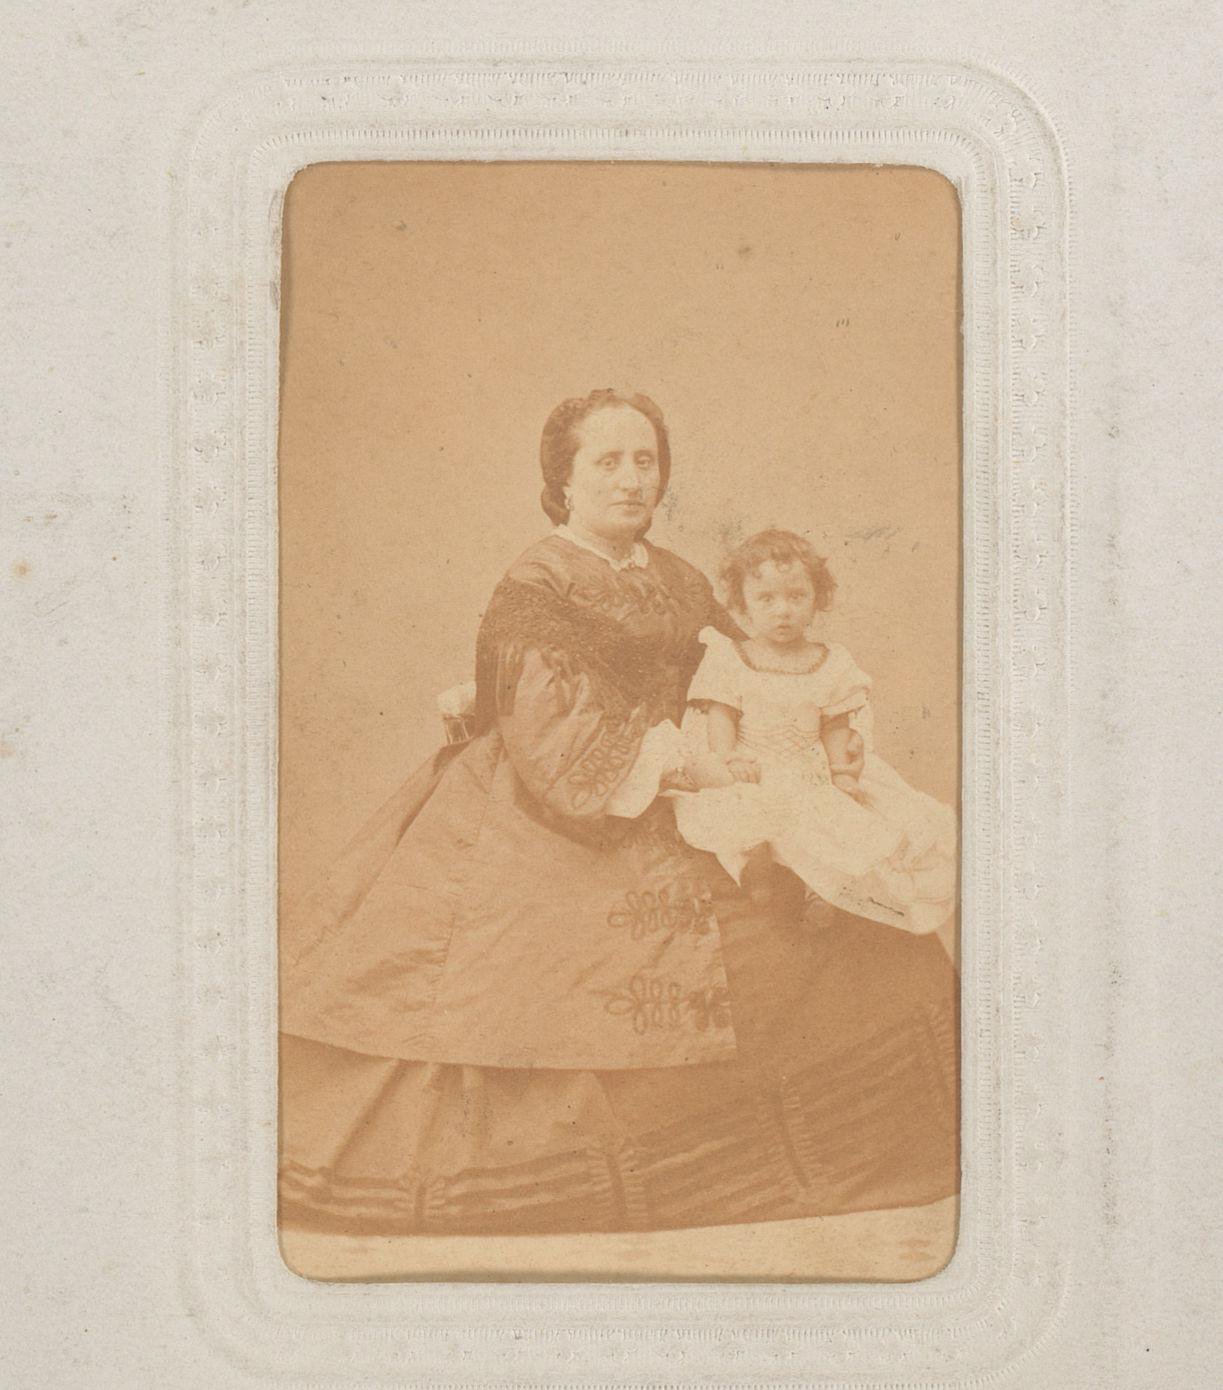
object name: carte de visite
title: Portret van een moeder met kind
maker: l. sellier et avrillon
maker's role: fotostudio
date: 1860-1890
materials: cardboard, photographic support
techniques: albumen print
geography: a coruña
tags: mother and baby or young child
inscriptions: inscription: ‘L. Sellier et Avrillon/ Fotografos/ Acevedo 19/ Coruña’